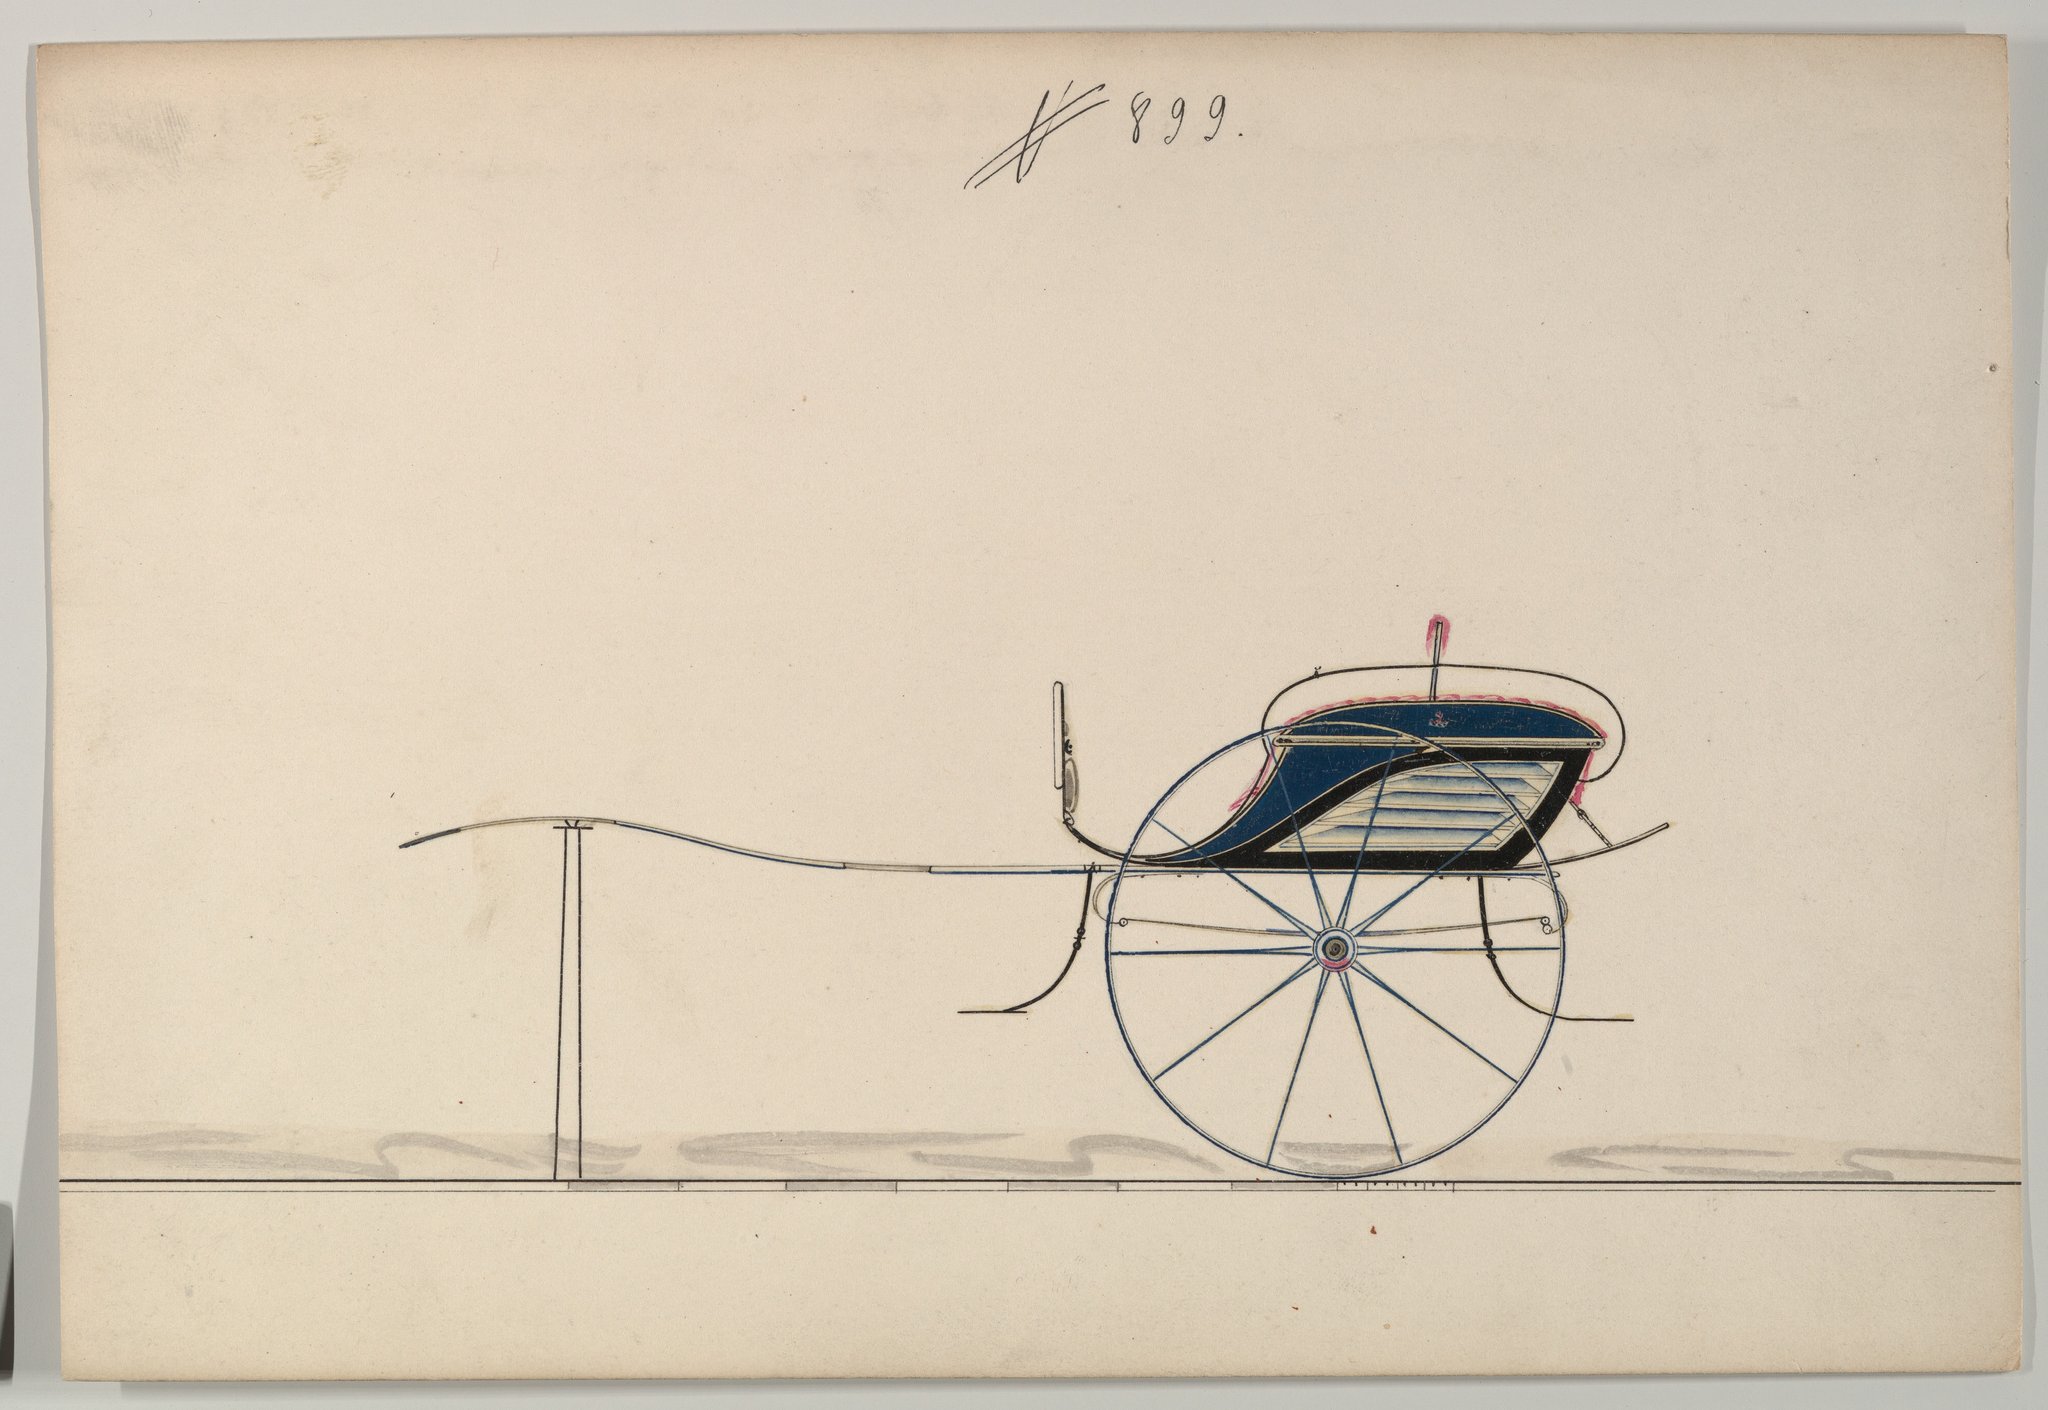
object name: drawing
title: Dog Cart # 899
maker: brewster & co.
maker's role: manufacturer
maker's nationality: american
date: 1870-1874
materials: gouache, gum arabic, ink, watercolor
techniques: pen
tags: carriages